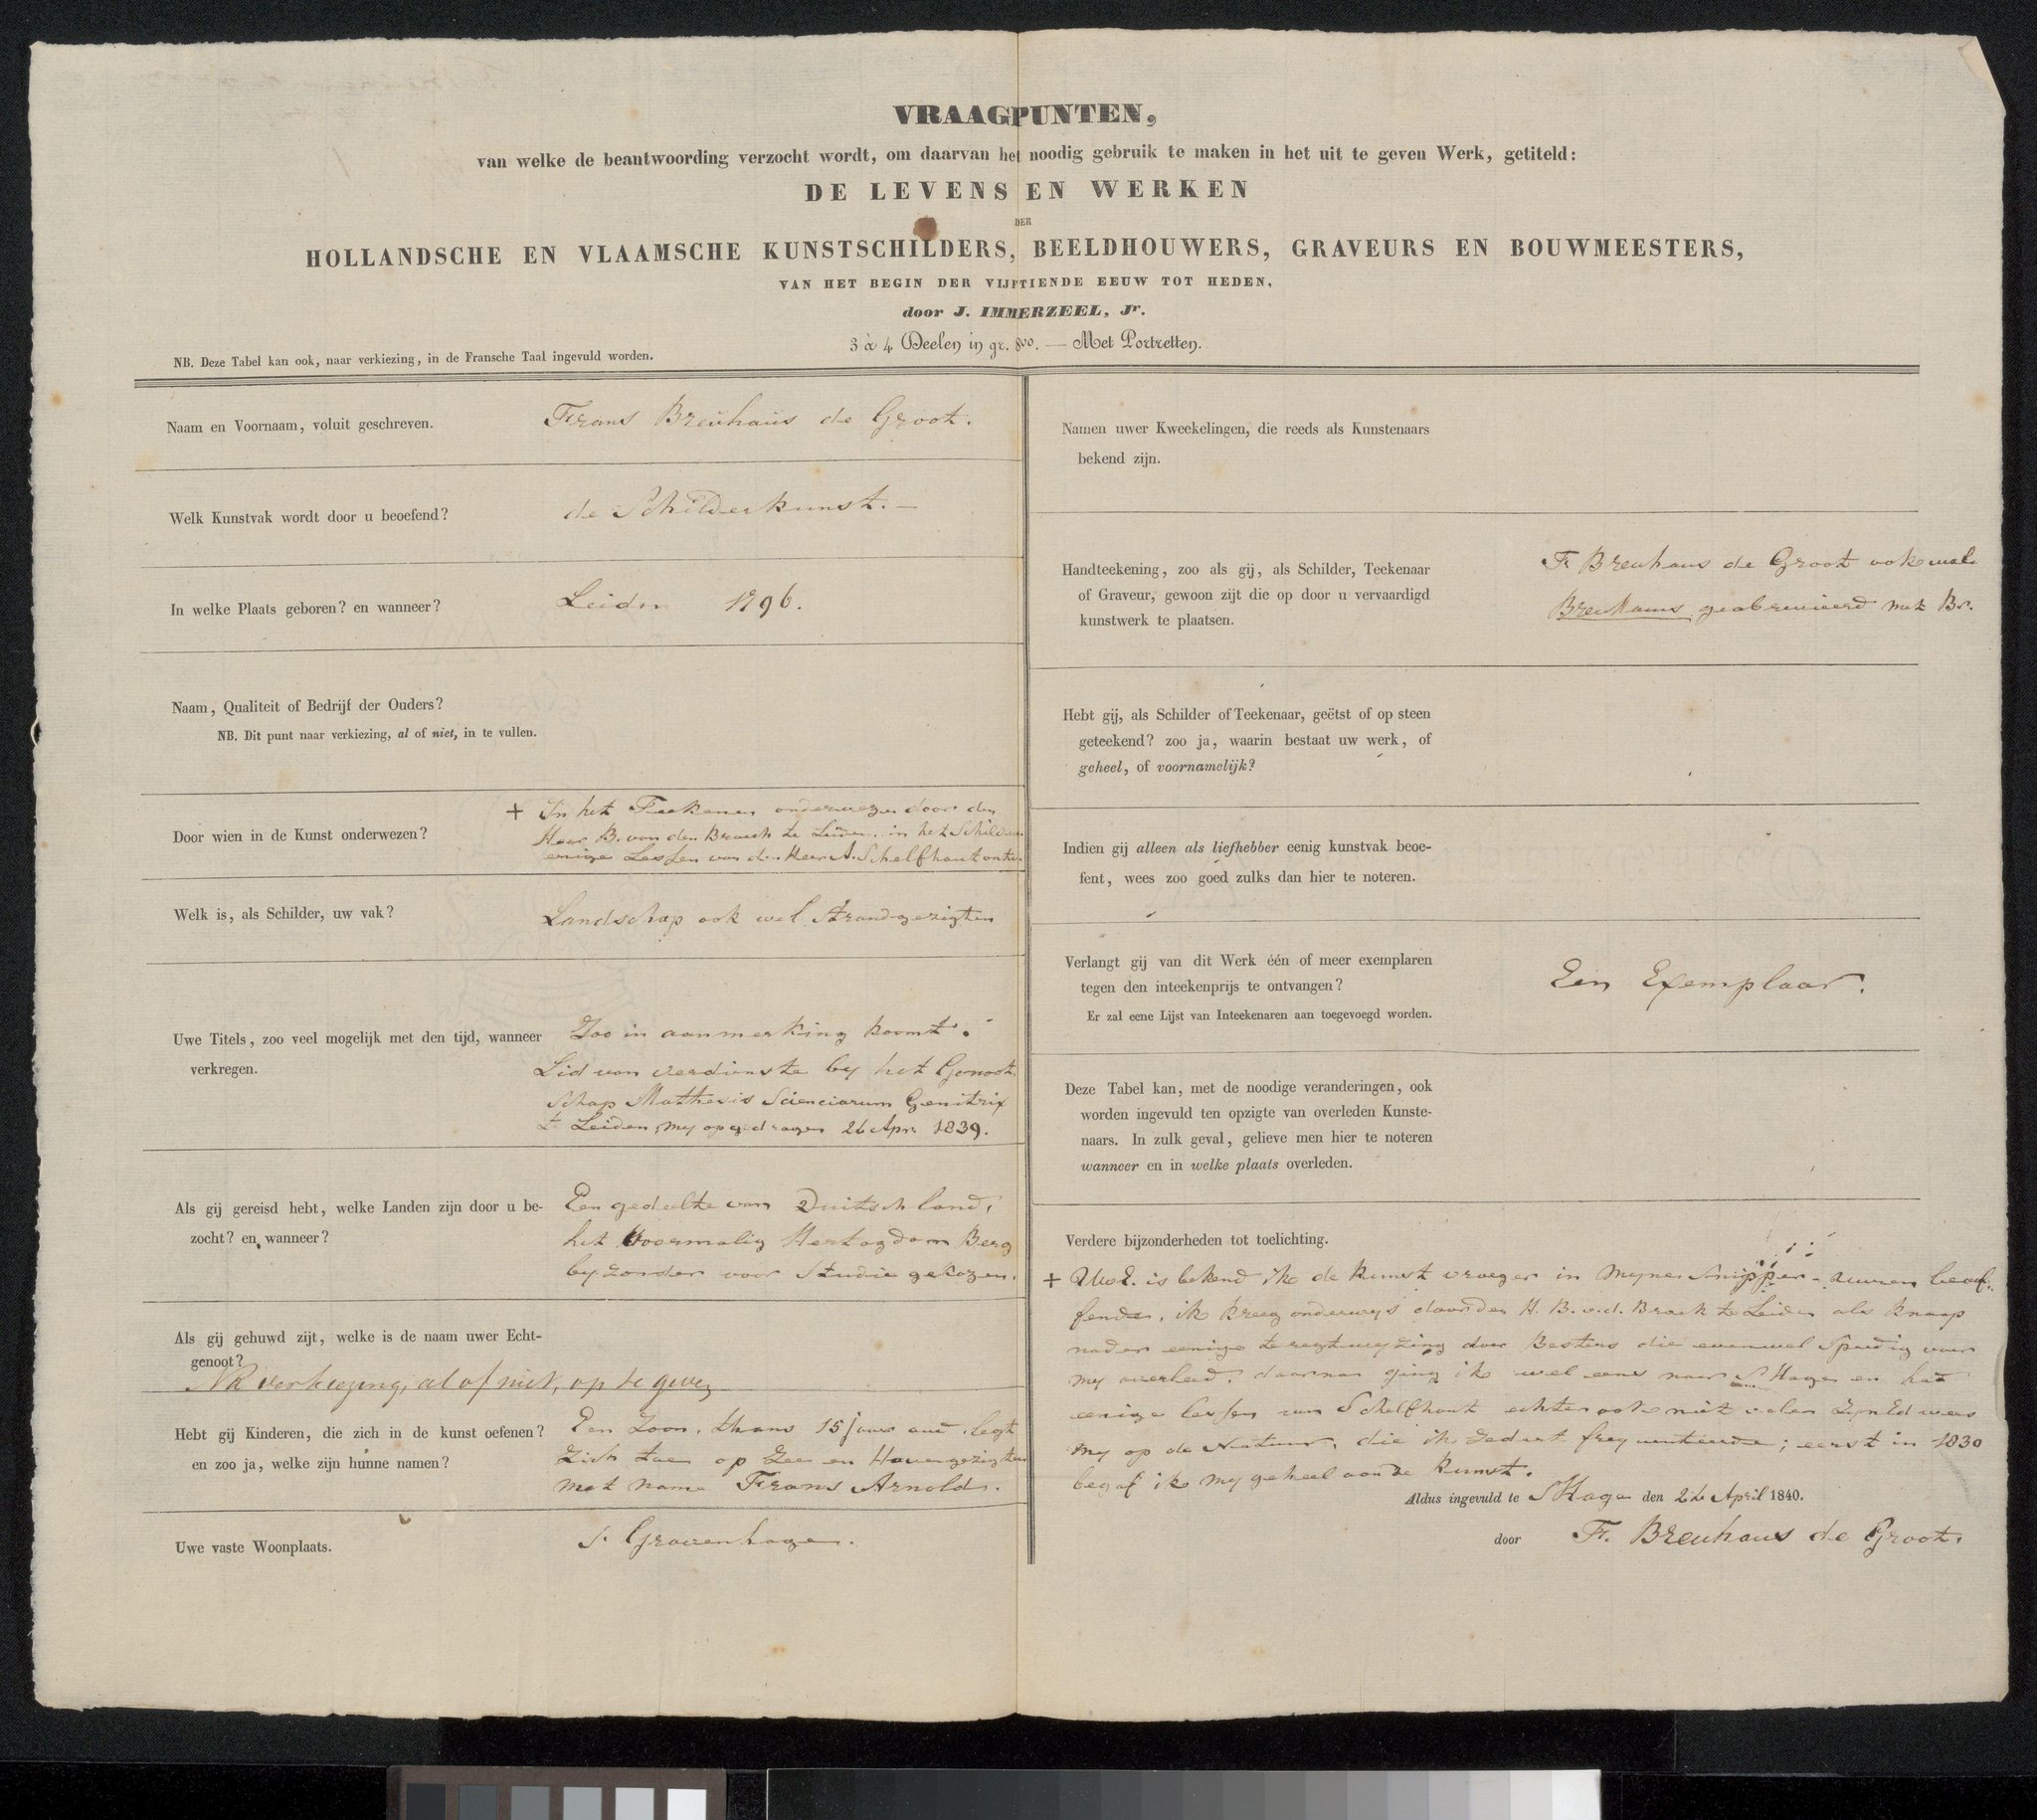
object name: questionnaire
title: Enquêteformulier ingevuld door Frans Breuhaus de Groot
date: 1840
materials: ink, paper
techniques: pen, printing, writing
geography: the hague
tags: leiden, the hague, print maker, draughtsman, frans breuhaus de groot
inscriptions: watermark, inscription: ‘Vraagpunten,/ van welke de beantwoording verzocht wordt, om daarvan het noodig gebruik te maken in het uit te geven Werk, getiteld: De levens en werken/ der Hollandsche en Vlaamsche kunstschilders, beeldhouwers,/ graveurs en bouwmeesters, van het begin der vijftiende eeuw tot heden/ door J. Immerzeel, Jr.’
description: Opgenomen in: Immerzeel, J. Jr., De levens en werken der Hollandsche en Vlaamsche kunstschilders, beeldhouwers, graveurs en bouwmeesters, van het begin der vijftiende eeuw tot heden, Amsterdam: J.C. van Kesteren, 1842-1843.